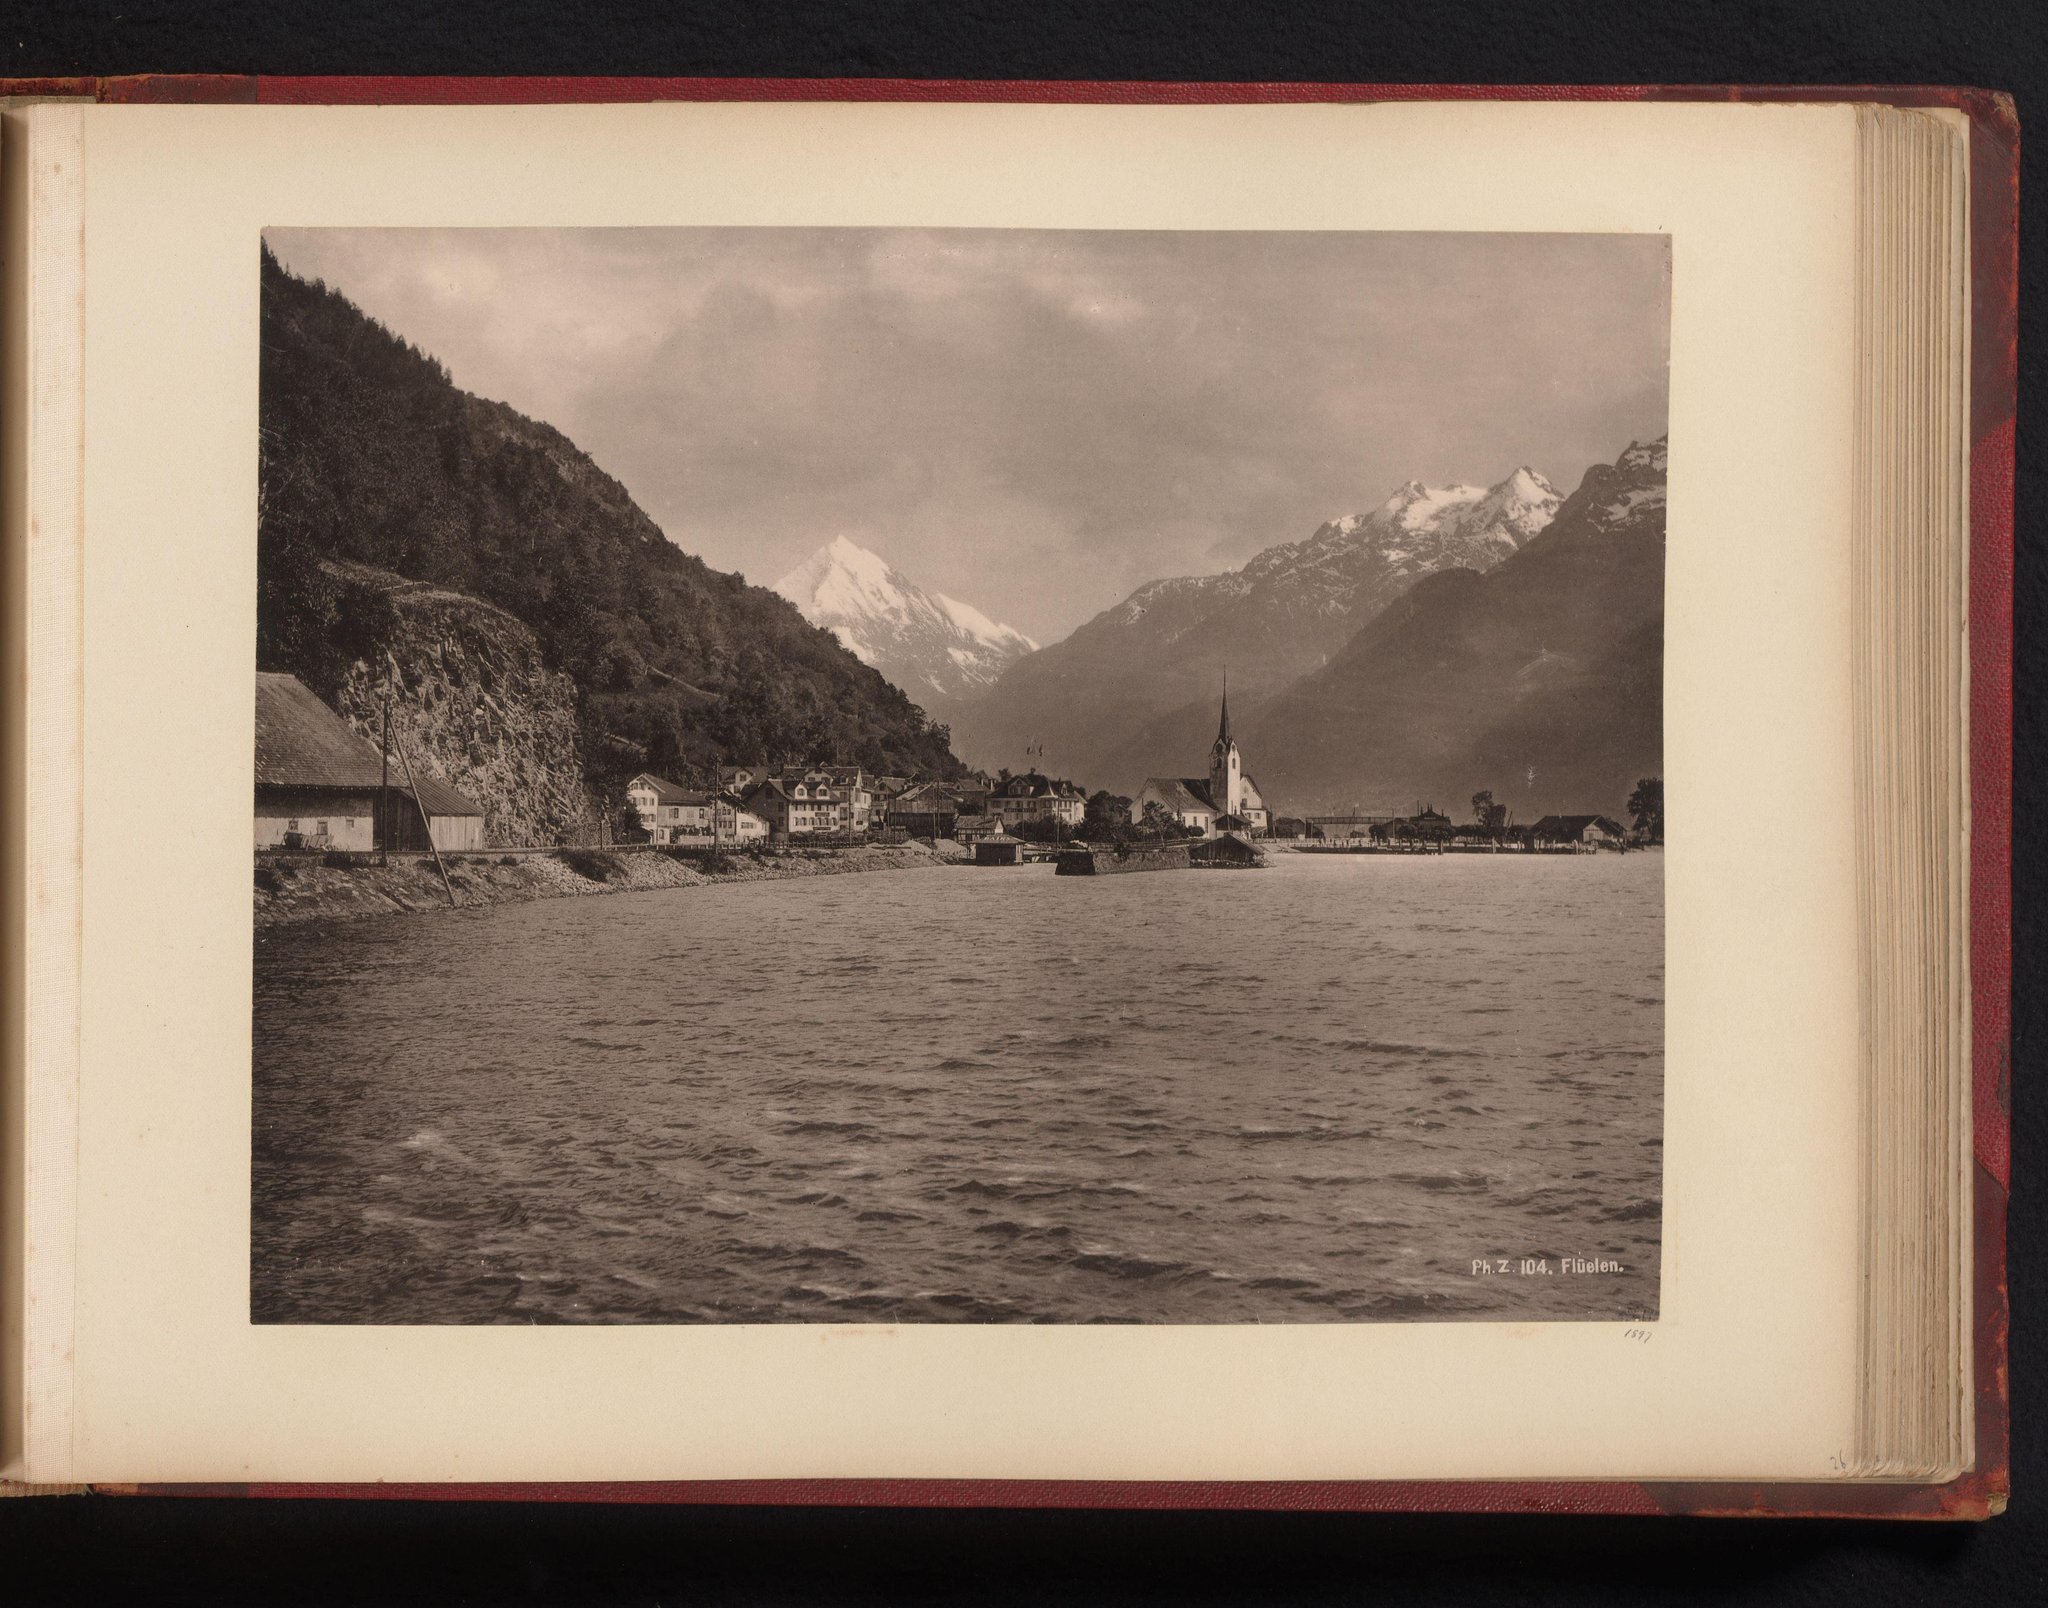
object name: album leaf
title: Gezicht op Flüelen te Zwitserland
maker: Anonymous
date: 1897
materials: paper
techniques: photograph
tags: city-view in general; 'veduta', lake, mountain-range, snow peaks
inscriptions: annotation: ‘1897’, inscription: ‘Ph. Z. 104. Flüelen’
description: Deze prent maakt deel uit van een album.